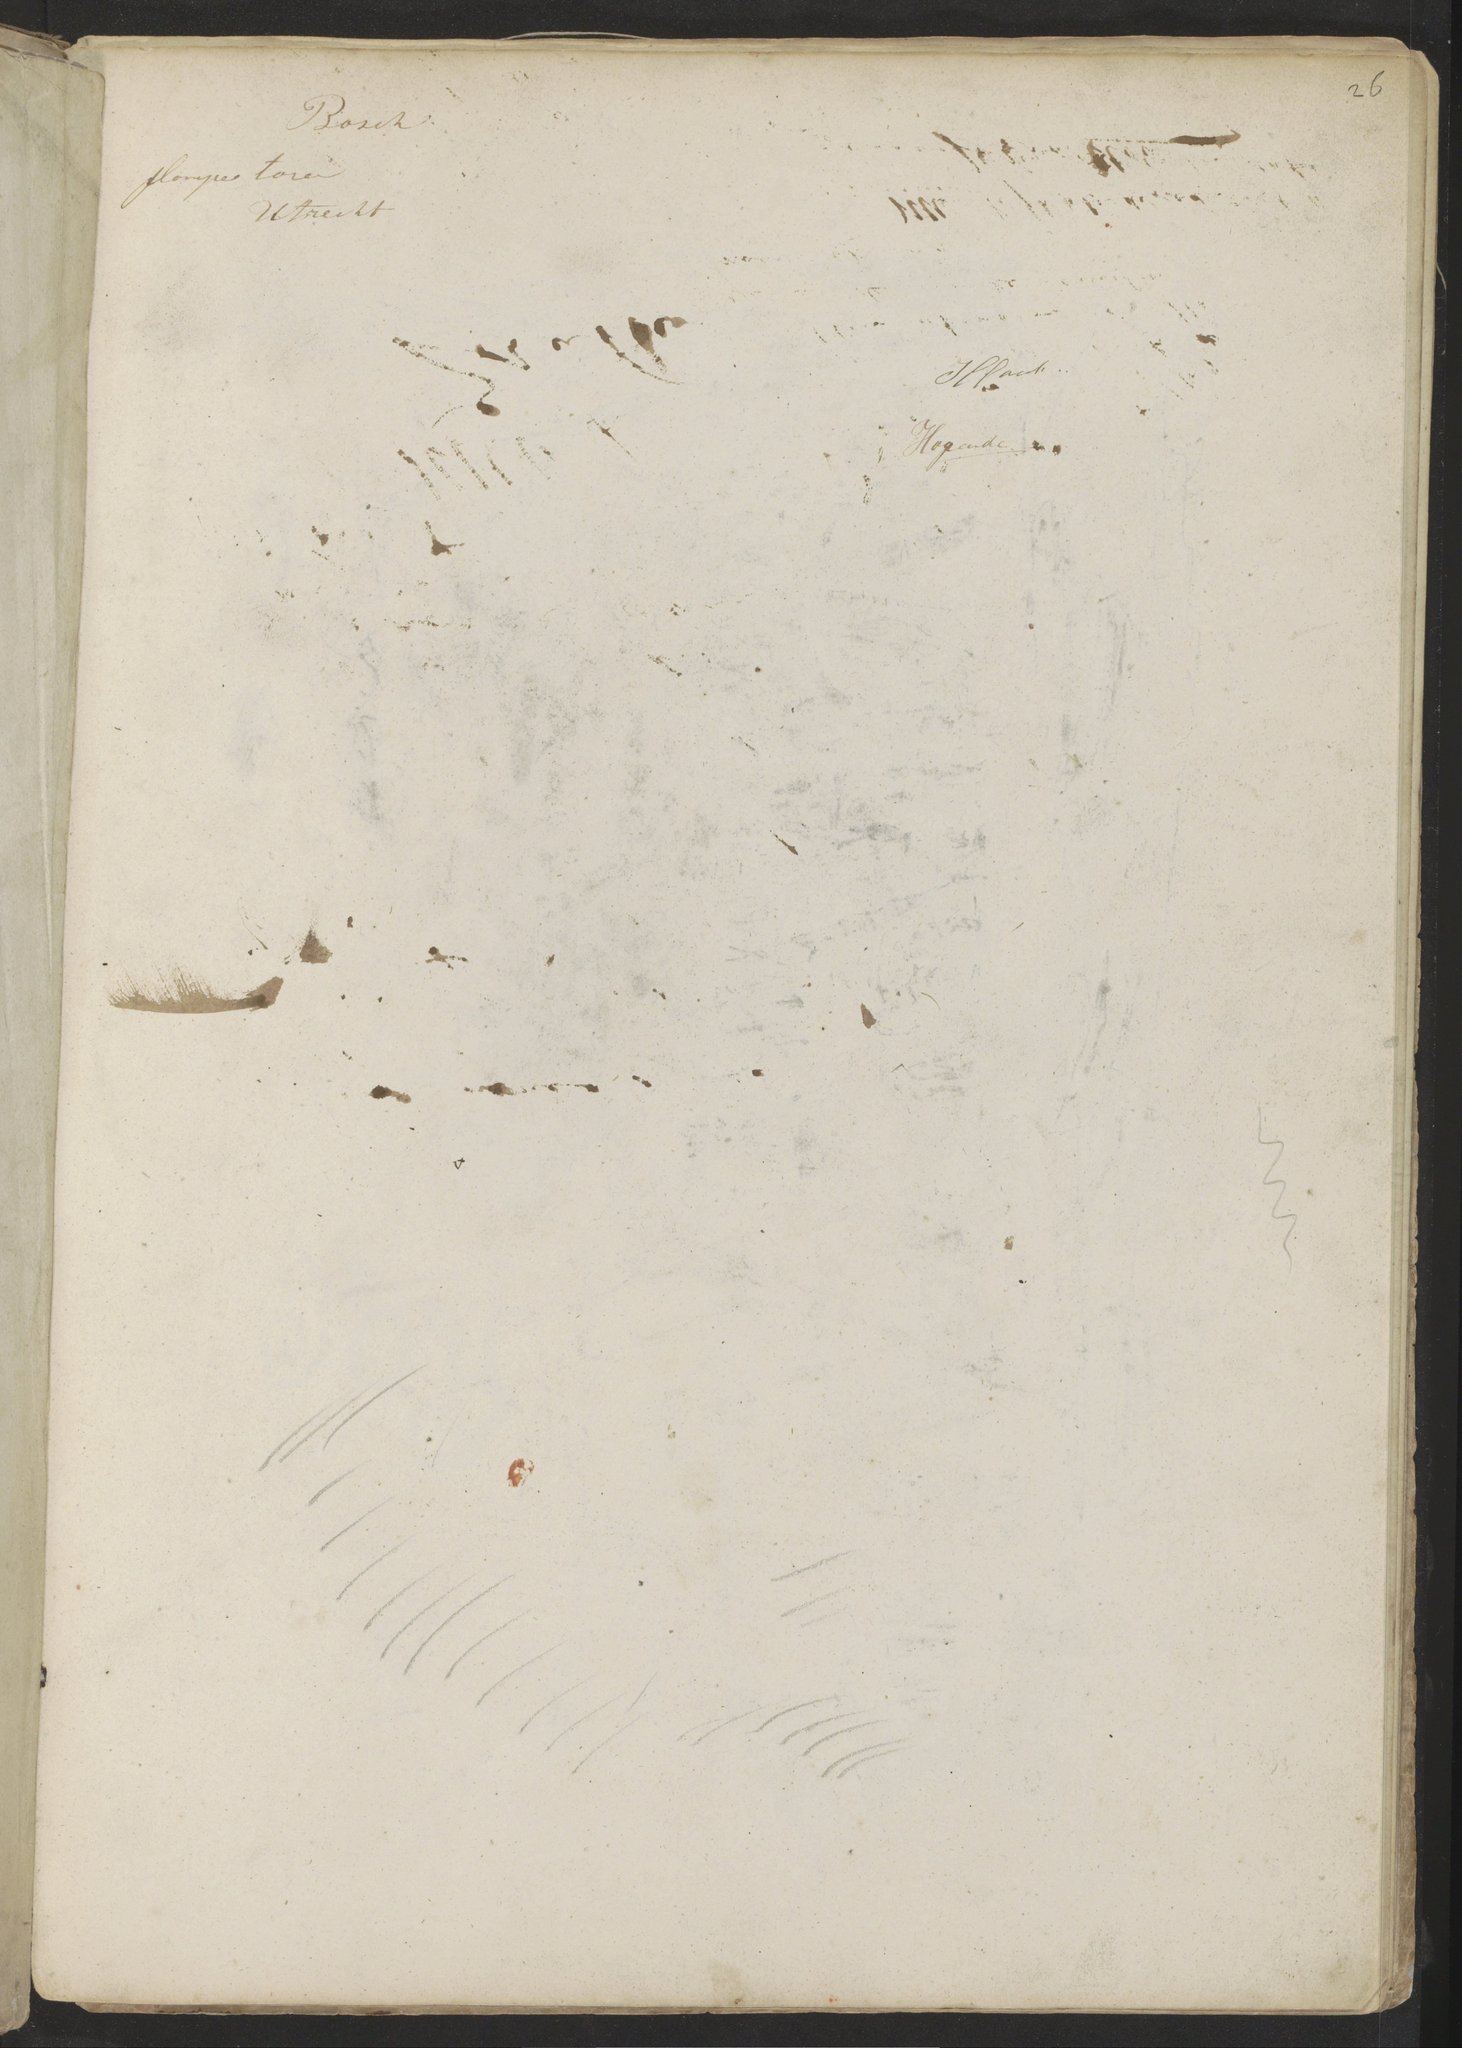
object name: sketchbook leaf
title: Notities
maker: johannes huybertus van hove bzn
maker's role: print maker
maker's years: 1827-1881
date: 1837-1881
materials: ink, paper, pencil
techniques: pen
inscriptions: annotation: ‘Bosch/ plompe toren/ Utrecht/ [...]’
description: Blad 26 recto uit een schetsboek met 33 bladen en 10 losse tekeningen.